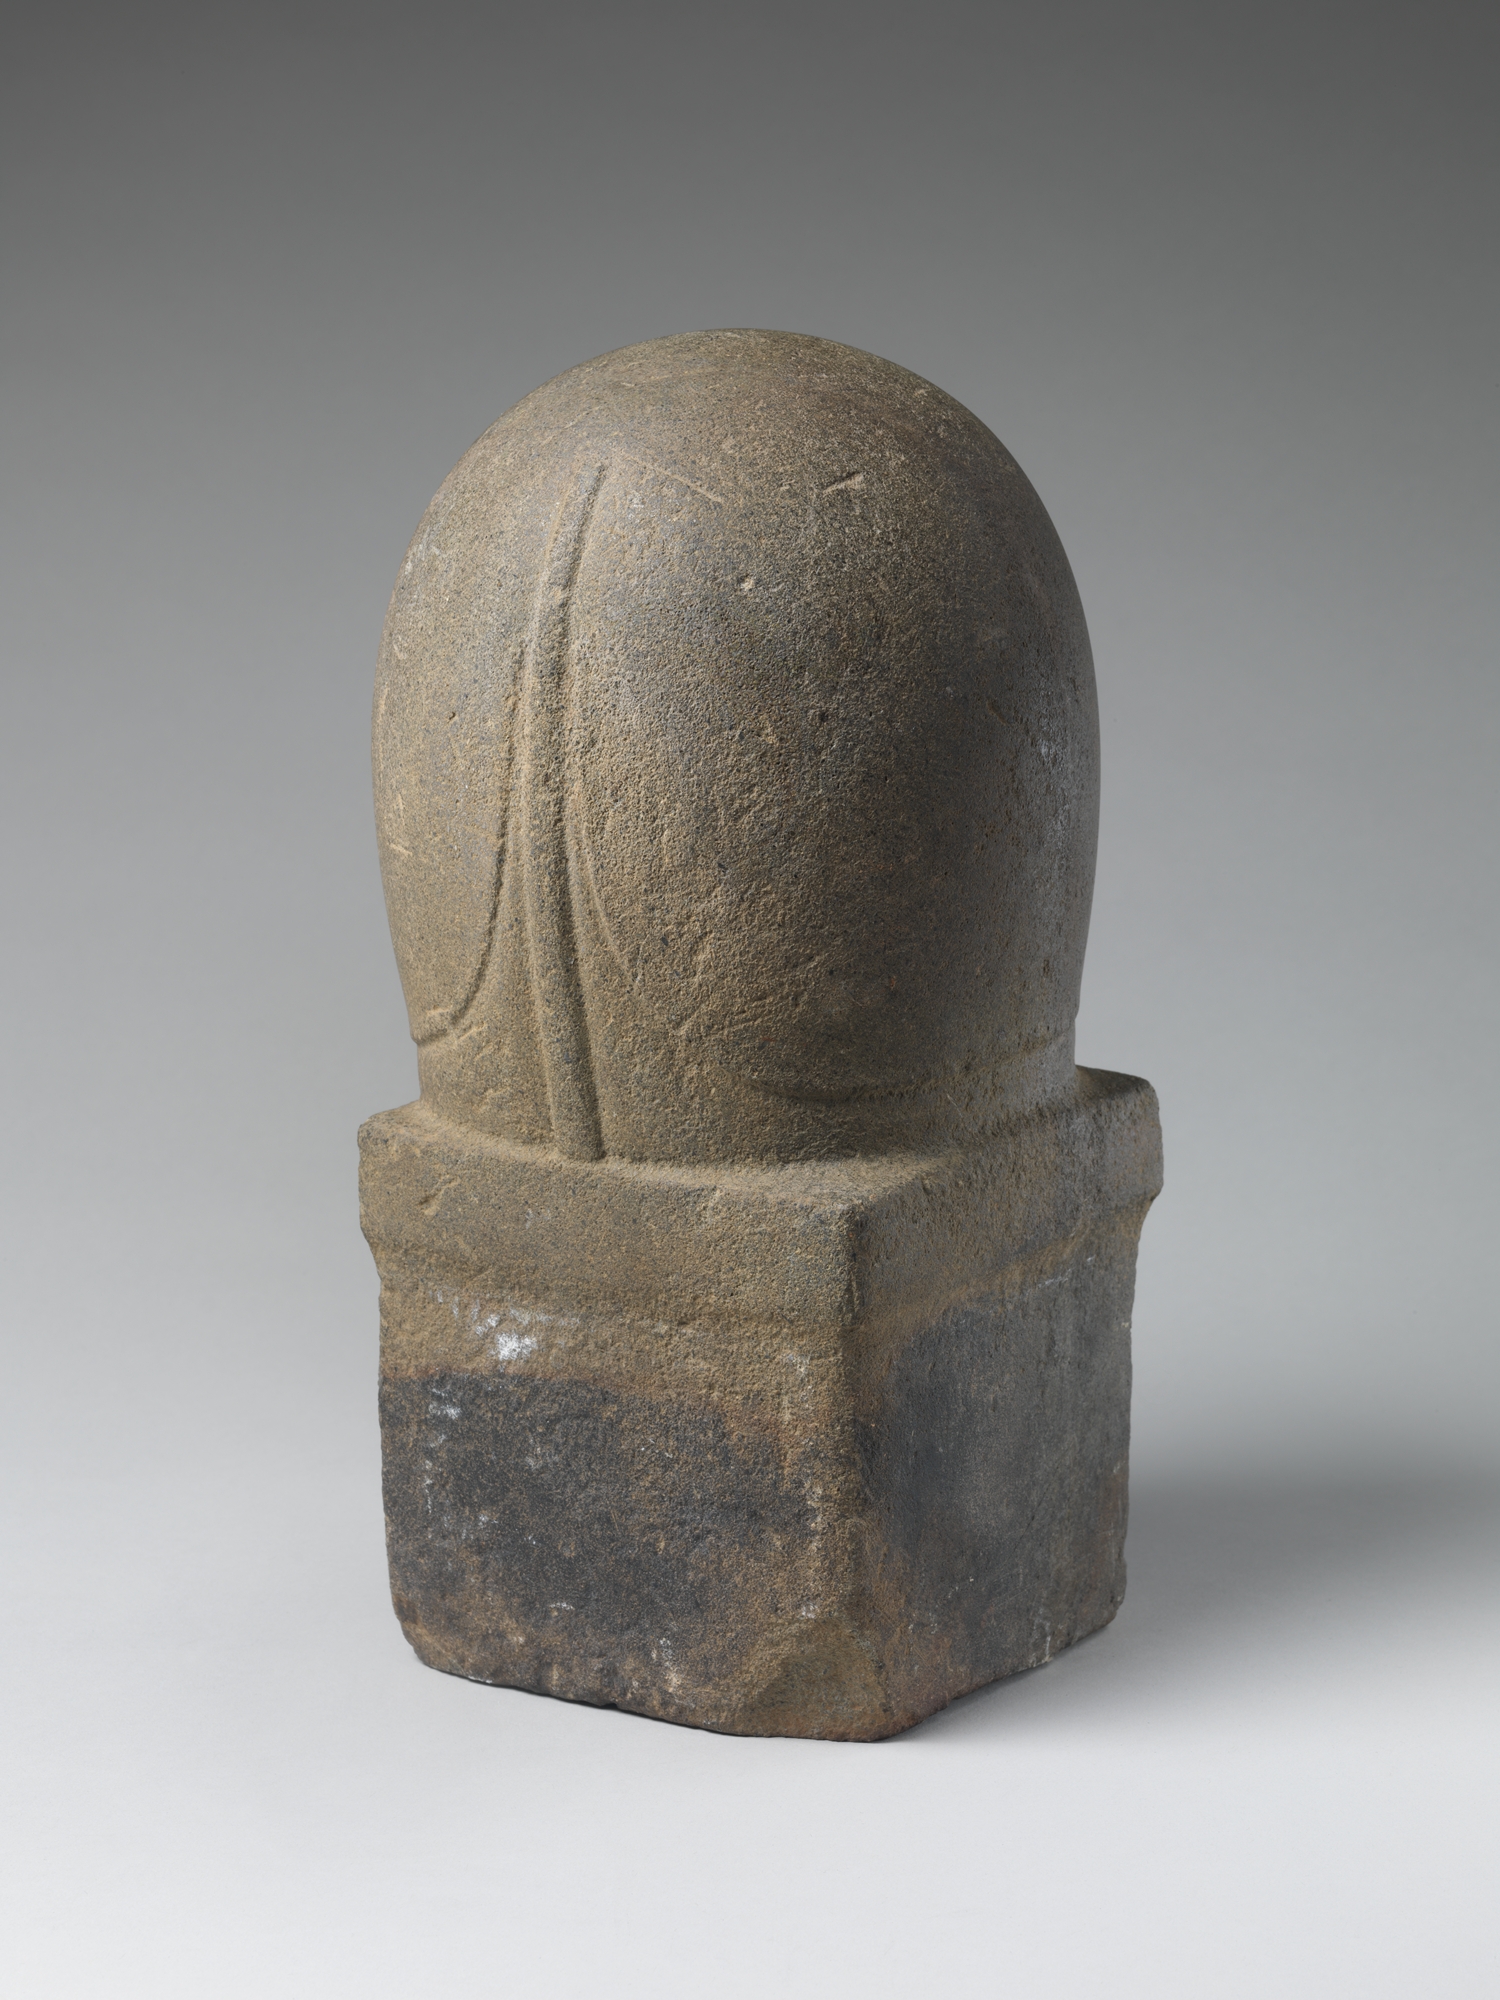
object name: linga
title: Shiva Linga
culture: southern thai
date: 601-800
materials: stone